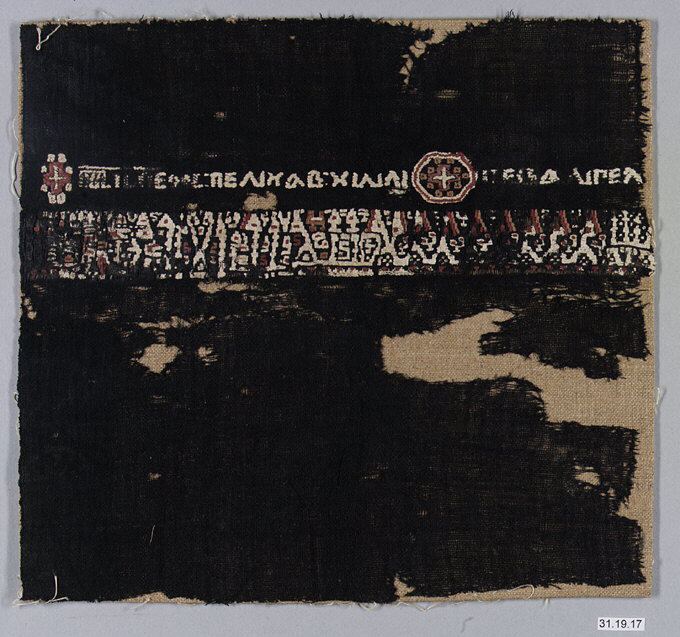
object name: textile fragment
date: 801-900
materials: linen, wool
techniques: weave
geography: egypt